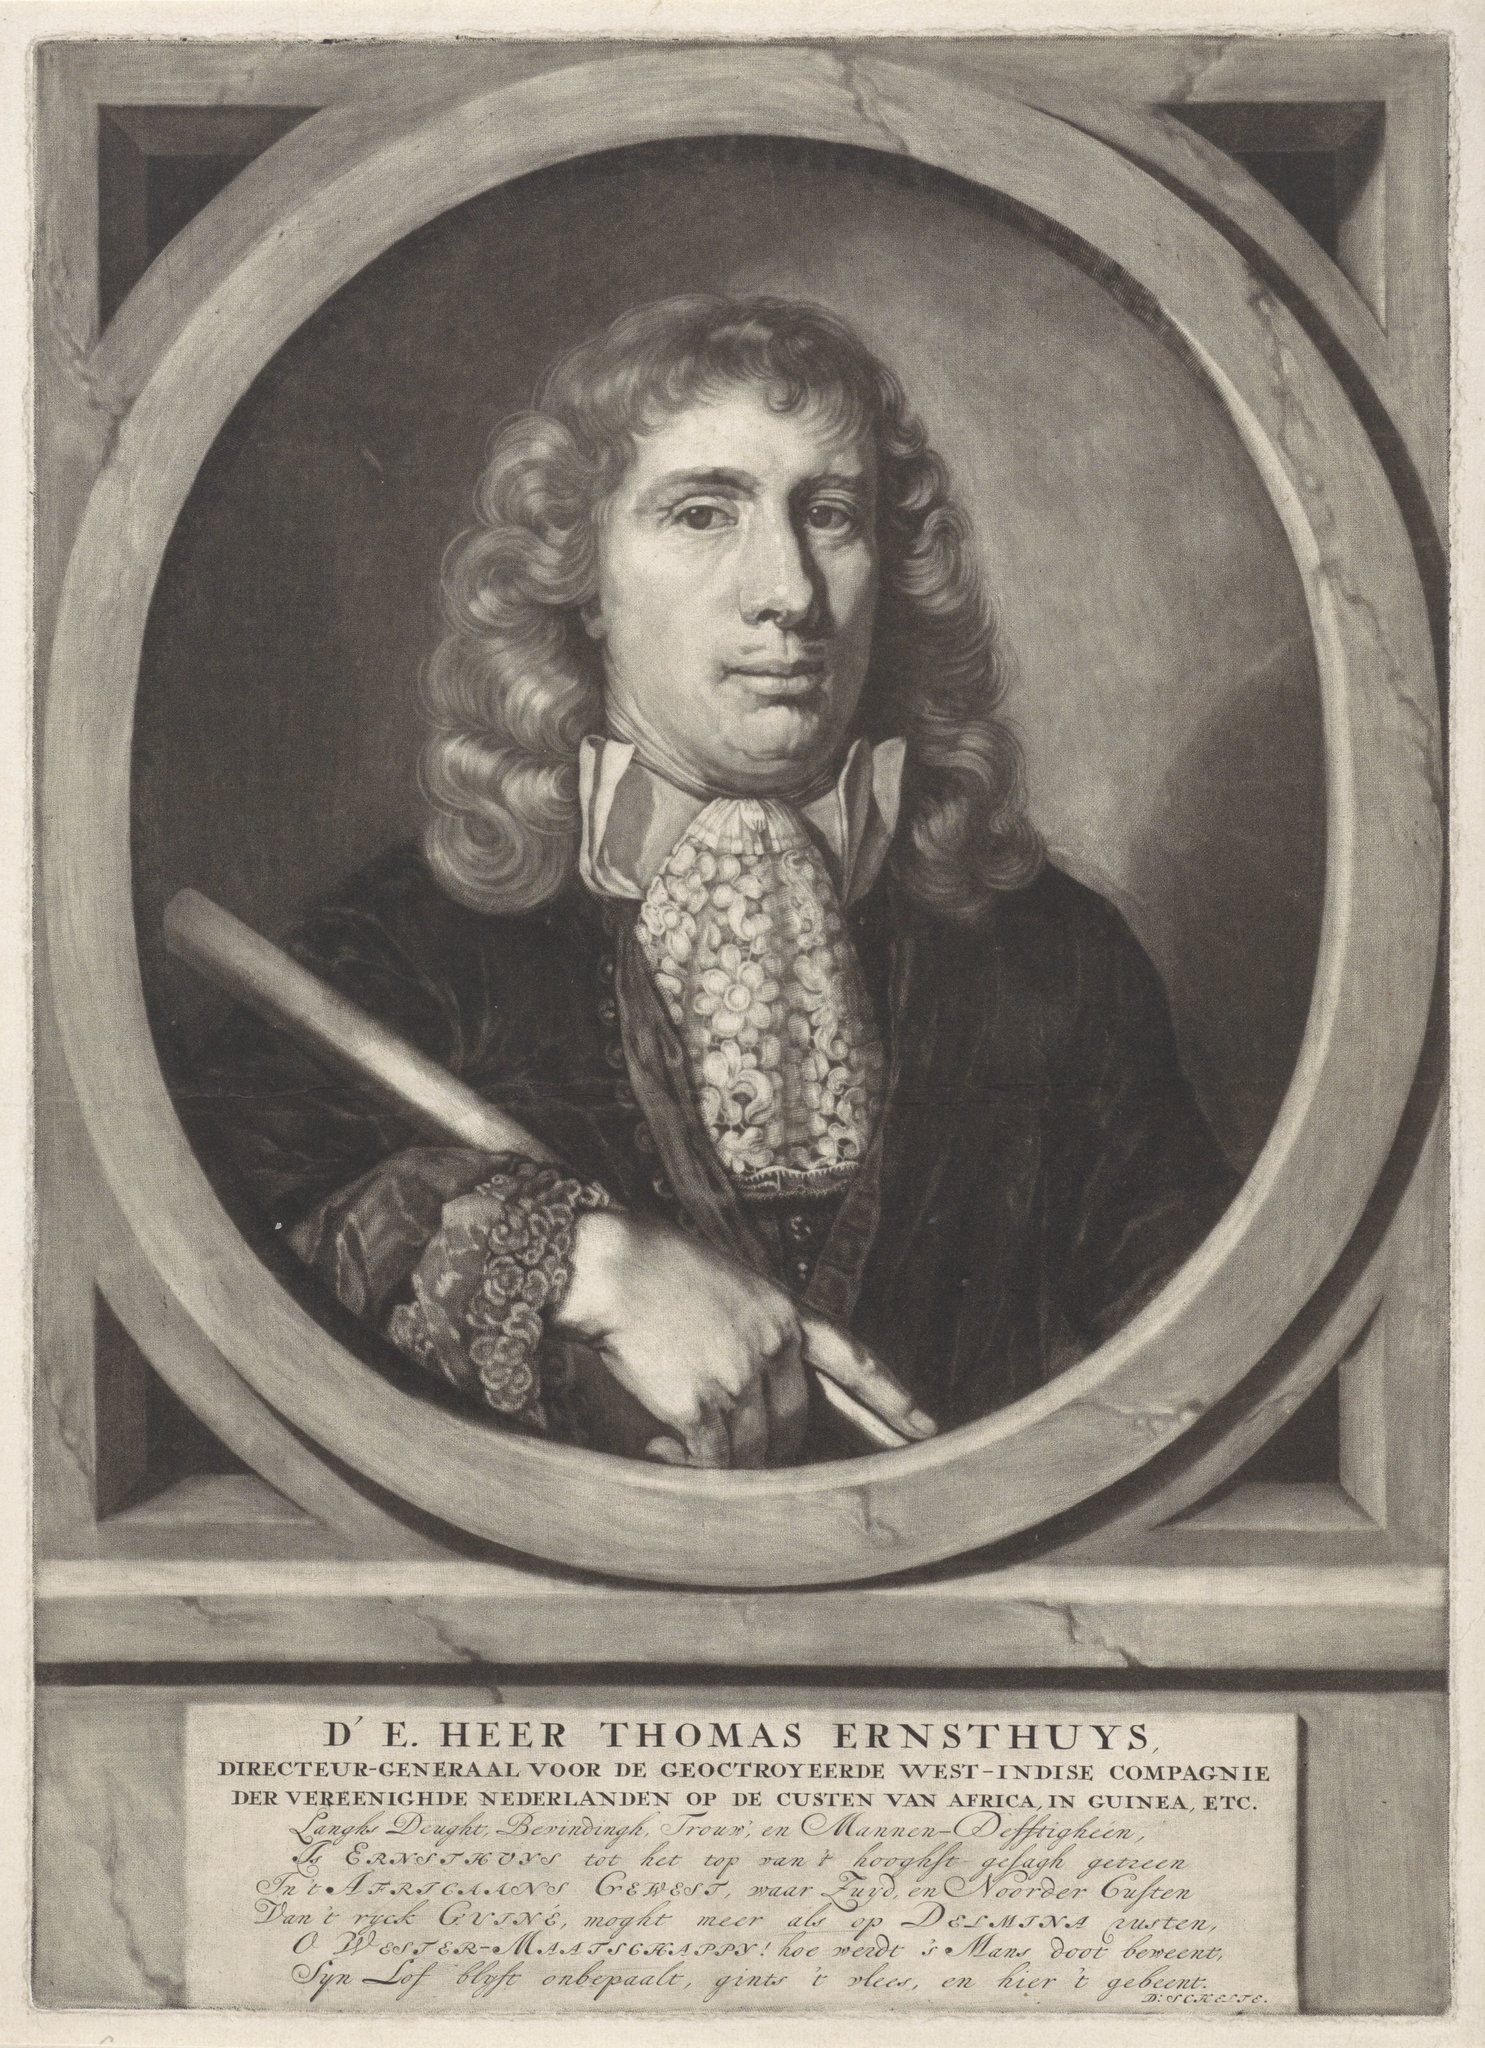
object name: print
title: Portret van Thomas Ernsthuys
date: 1684-1690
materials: paper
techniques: engraving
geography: amsterdam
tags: guinea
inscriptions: collector's mark: Lugt 2228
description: Portret van Thomas Ernsthuys, directeur-generaal van de West-Indische Compagnie, ter gelegenheid van zijn overlijden. Hij heeft in de rechterhand een staf. In de marge zijn naam, titels en een gedicht.